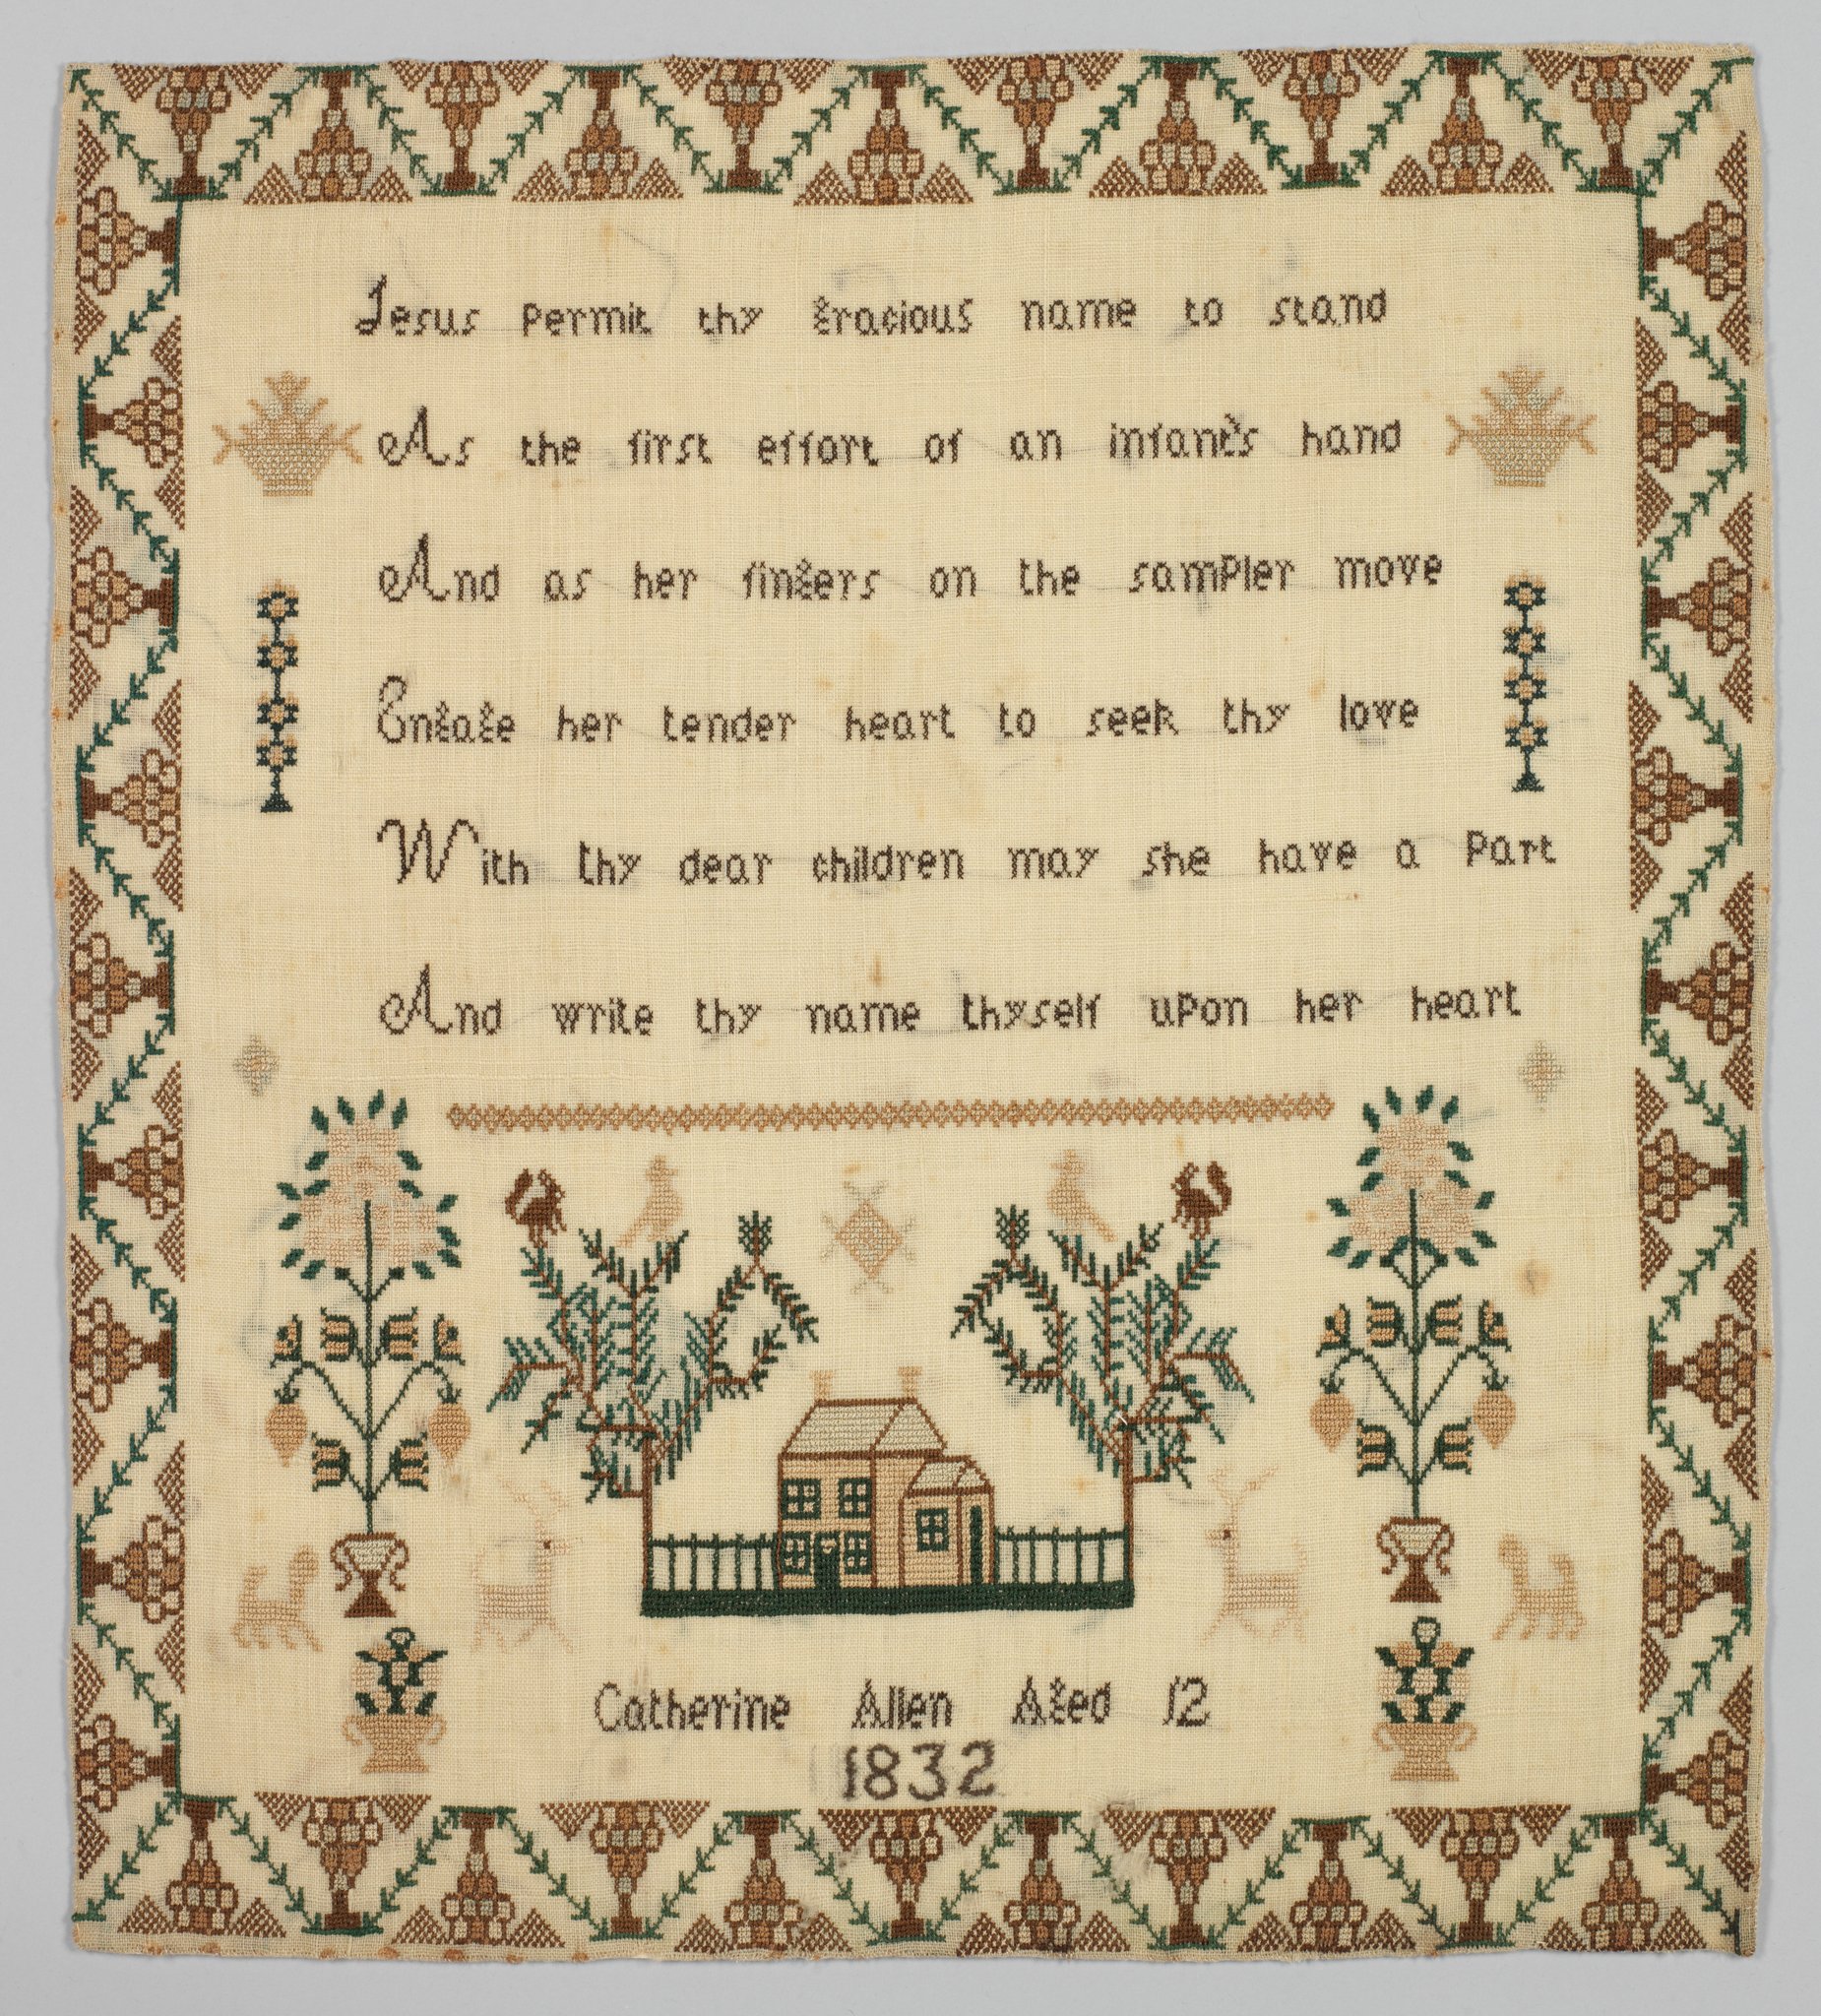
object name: sampler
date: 1832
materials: canvas, silk, wool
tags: houses,trees